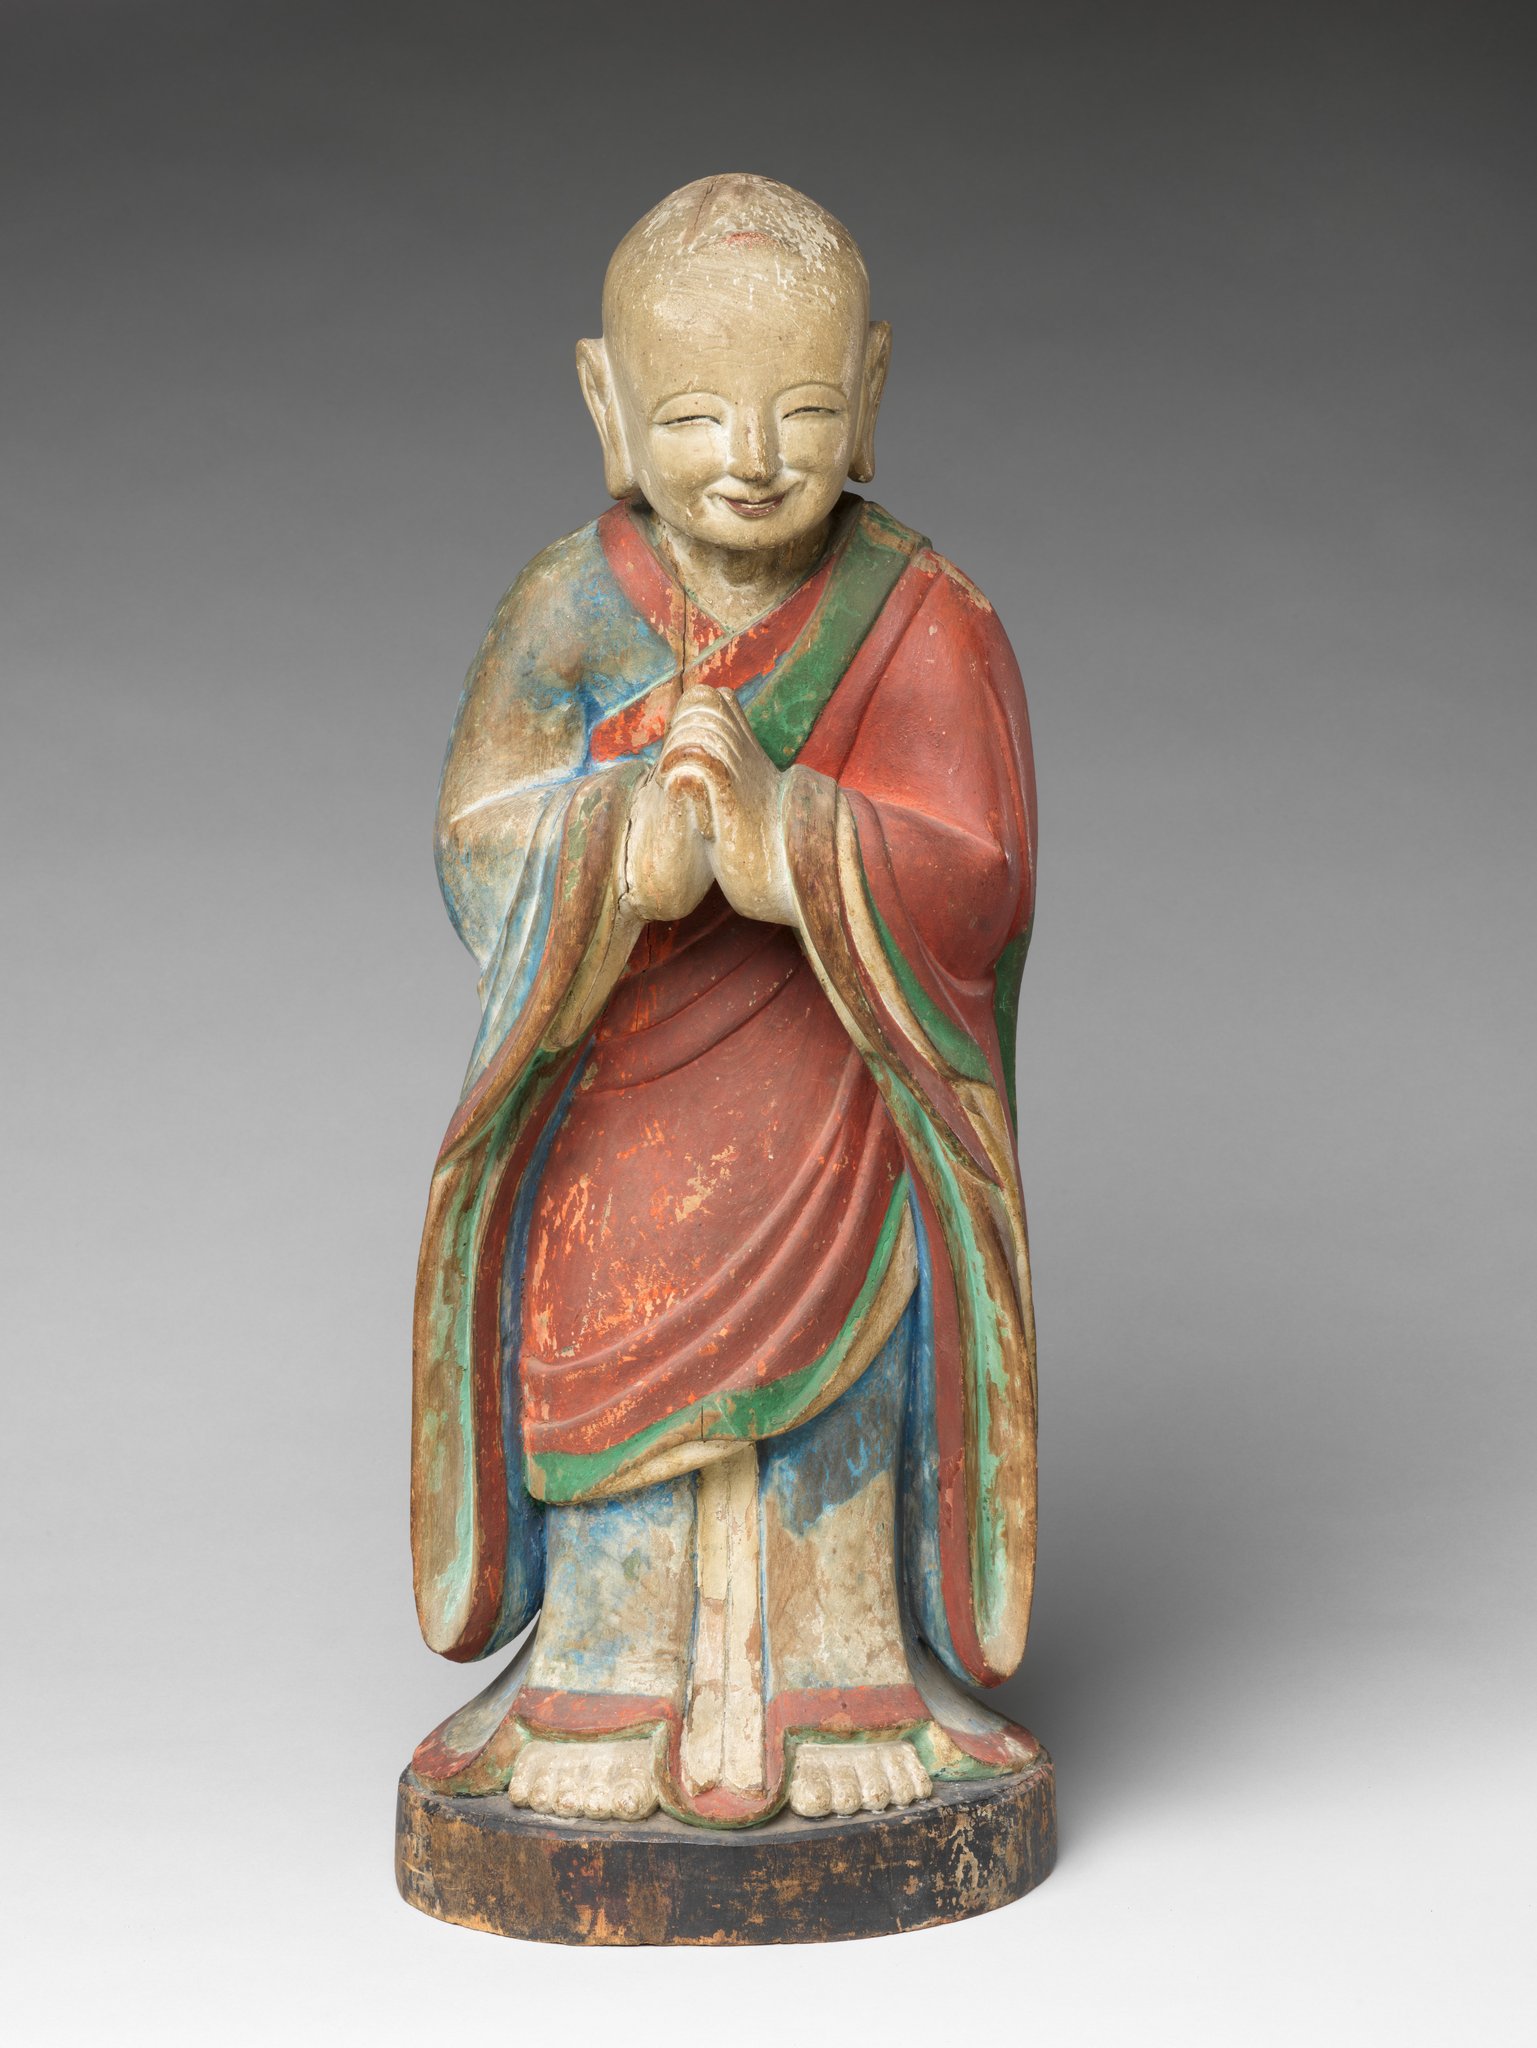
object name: figure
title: Kashyapa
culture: korean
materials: paint, wood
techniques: polychrome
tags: men,buddhism,monks